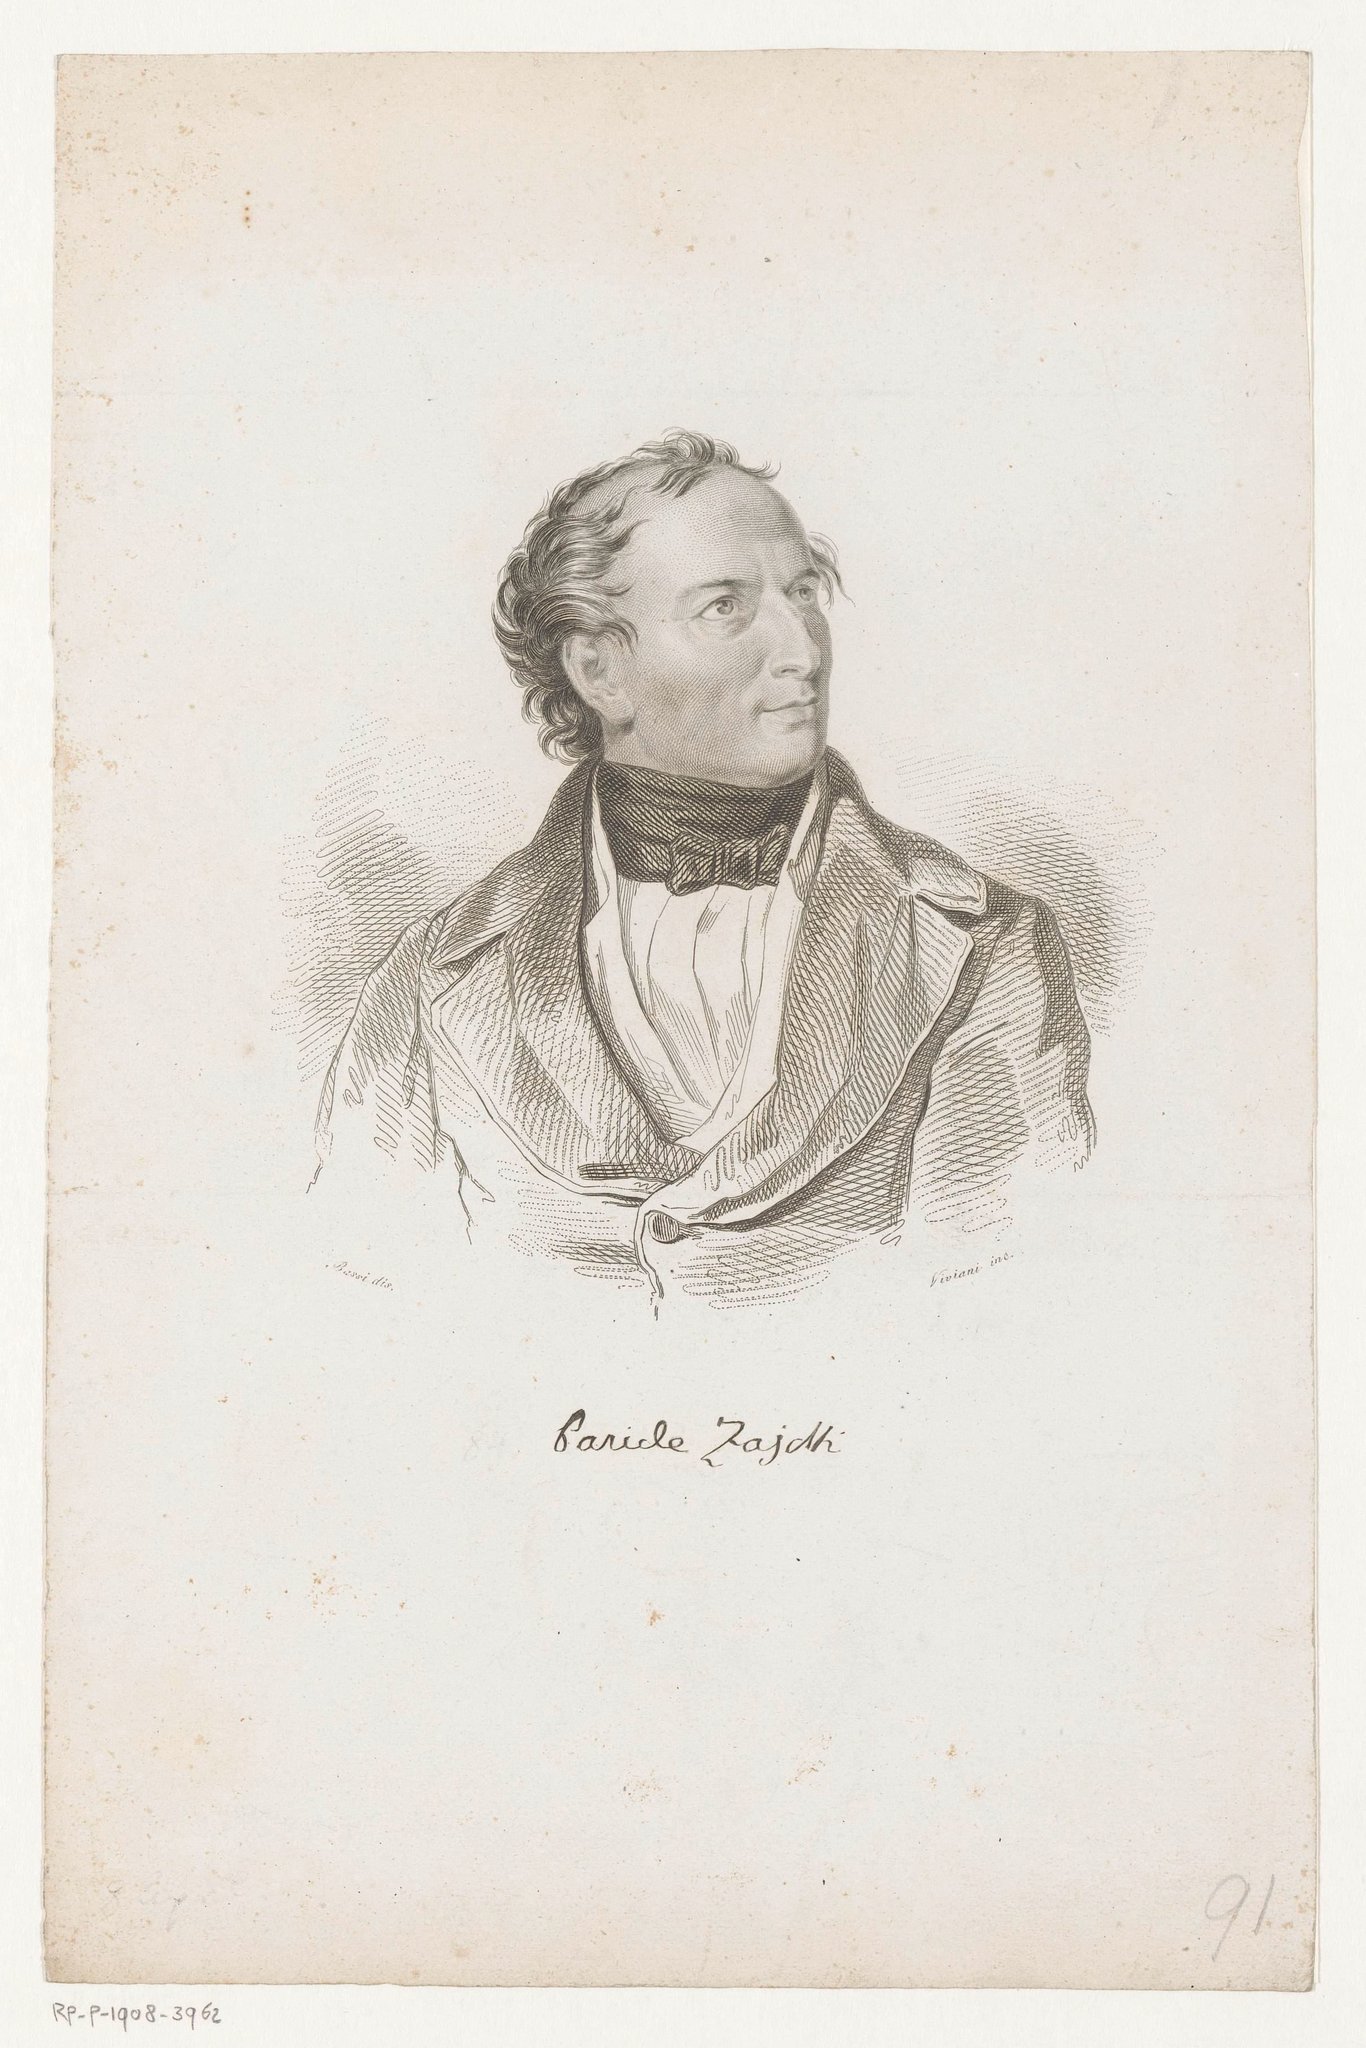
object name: print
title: Portret van een onbekende man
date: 1800-1899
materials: paper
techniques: engraving, etching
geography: italy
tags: historical persons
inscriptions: inscription: ‘[...]aride Zajdh’, collector's mark: Lugt 2228